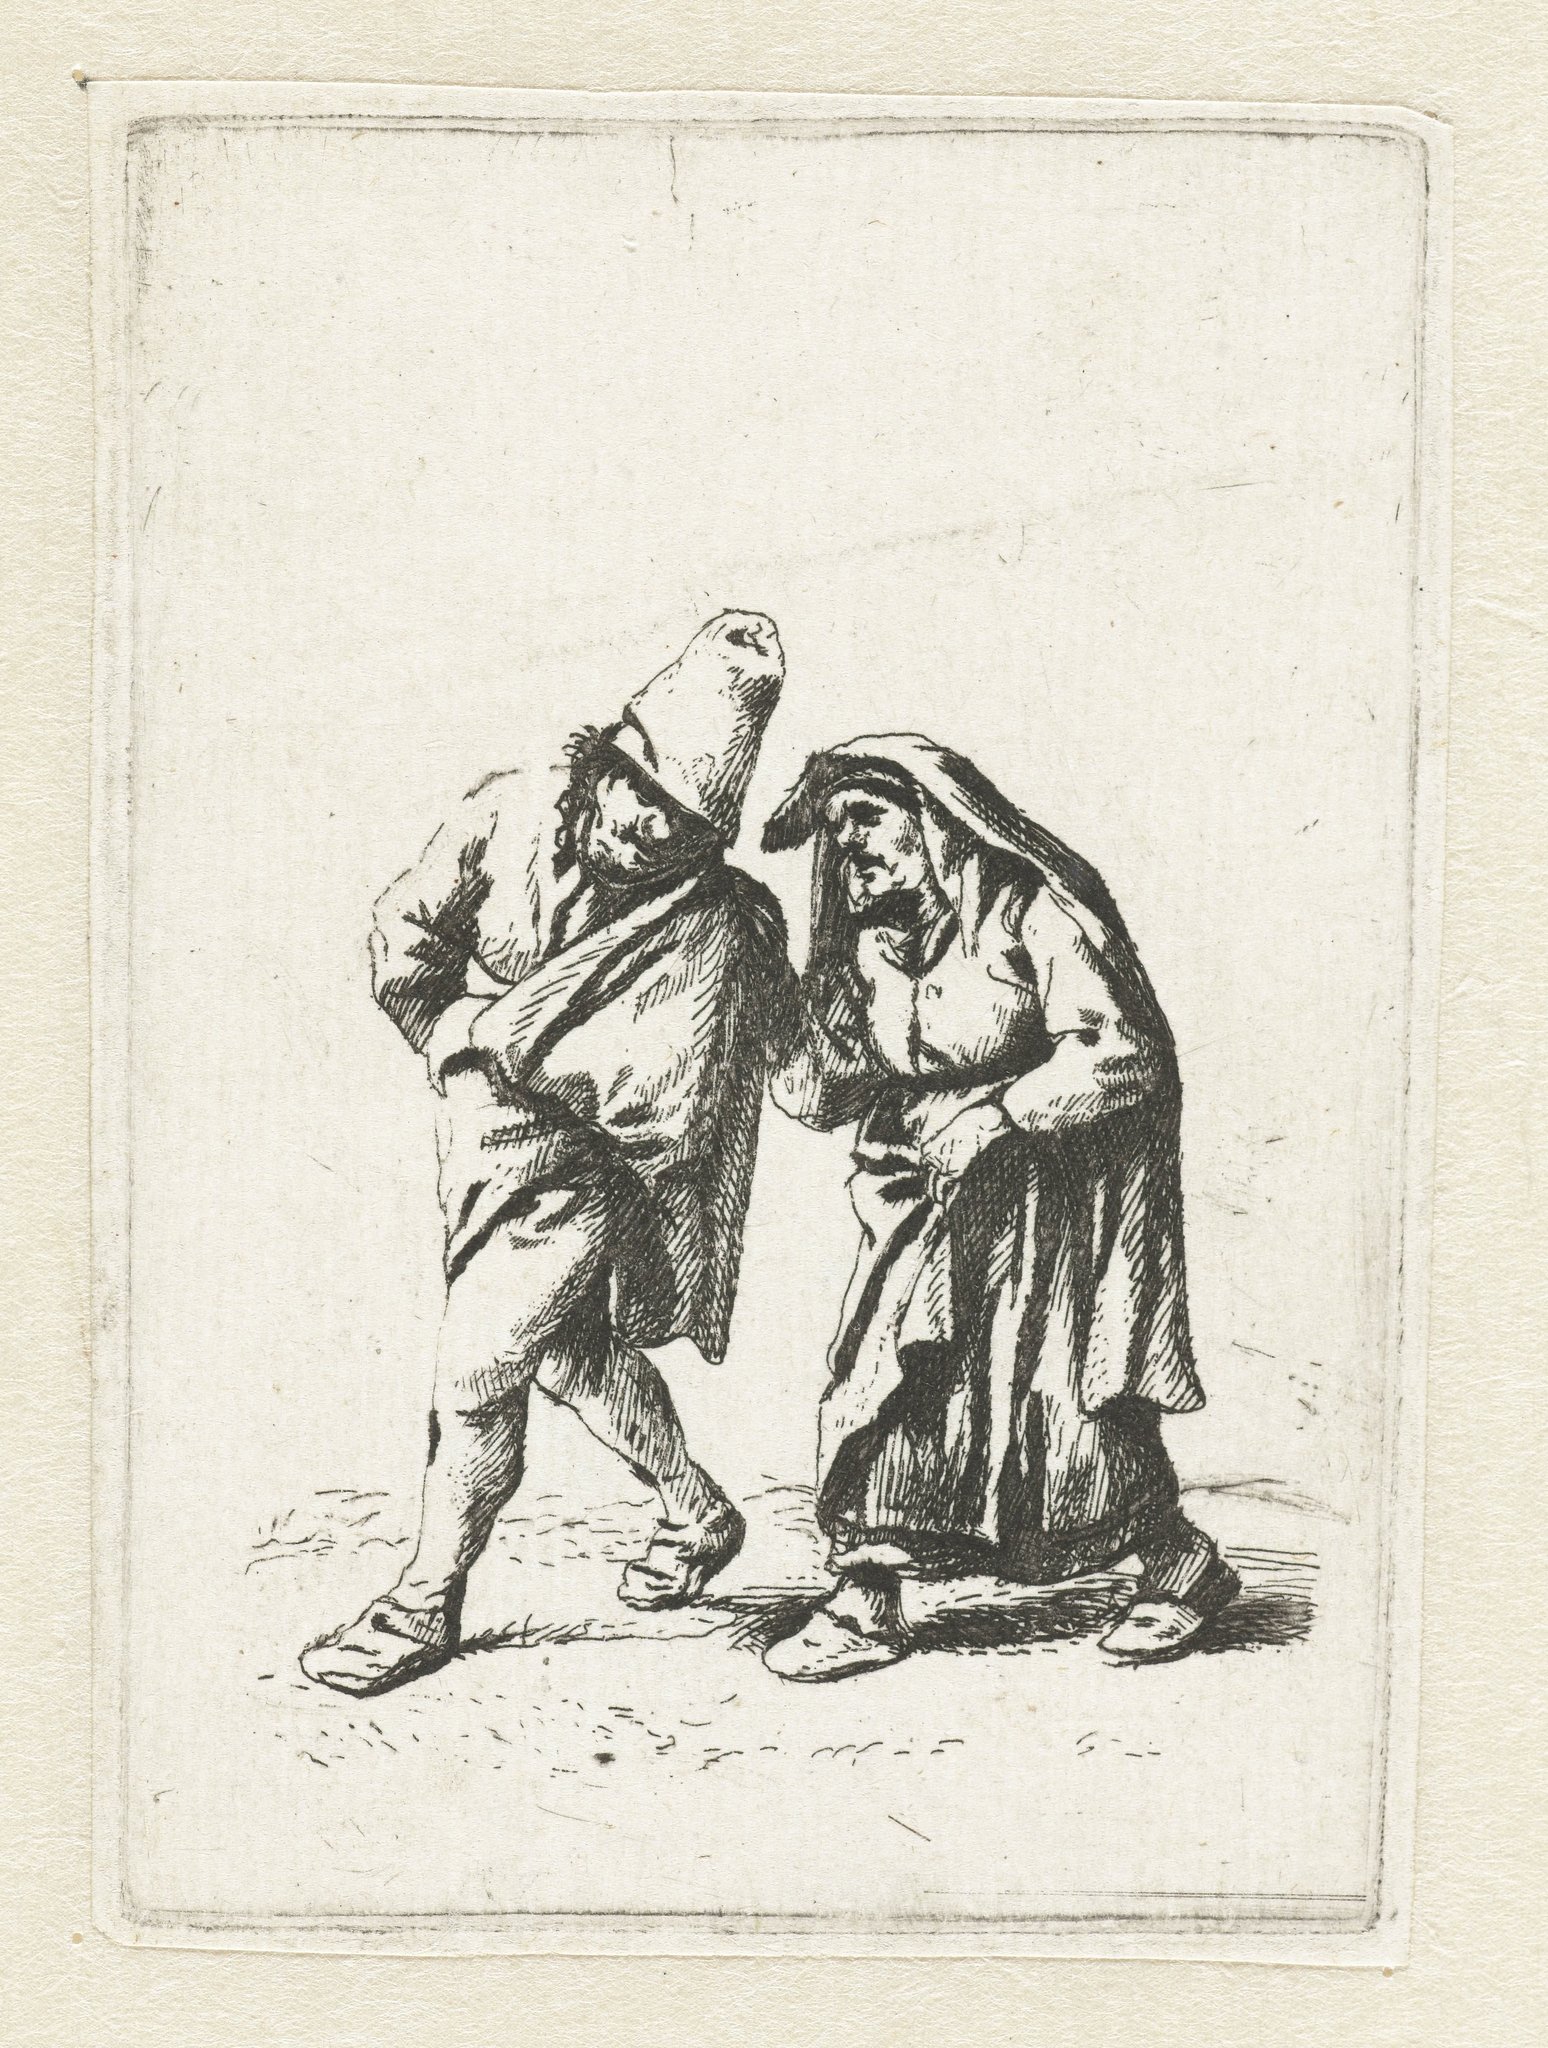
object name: kopie naar prent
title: Wandelend boerenpaar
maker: Anonymous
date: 1646-1745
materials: paper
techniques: etching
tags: farmers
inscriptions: collector's mark: Lugt 240